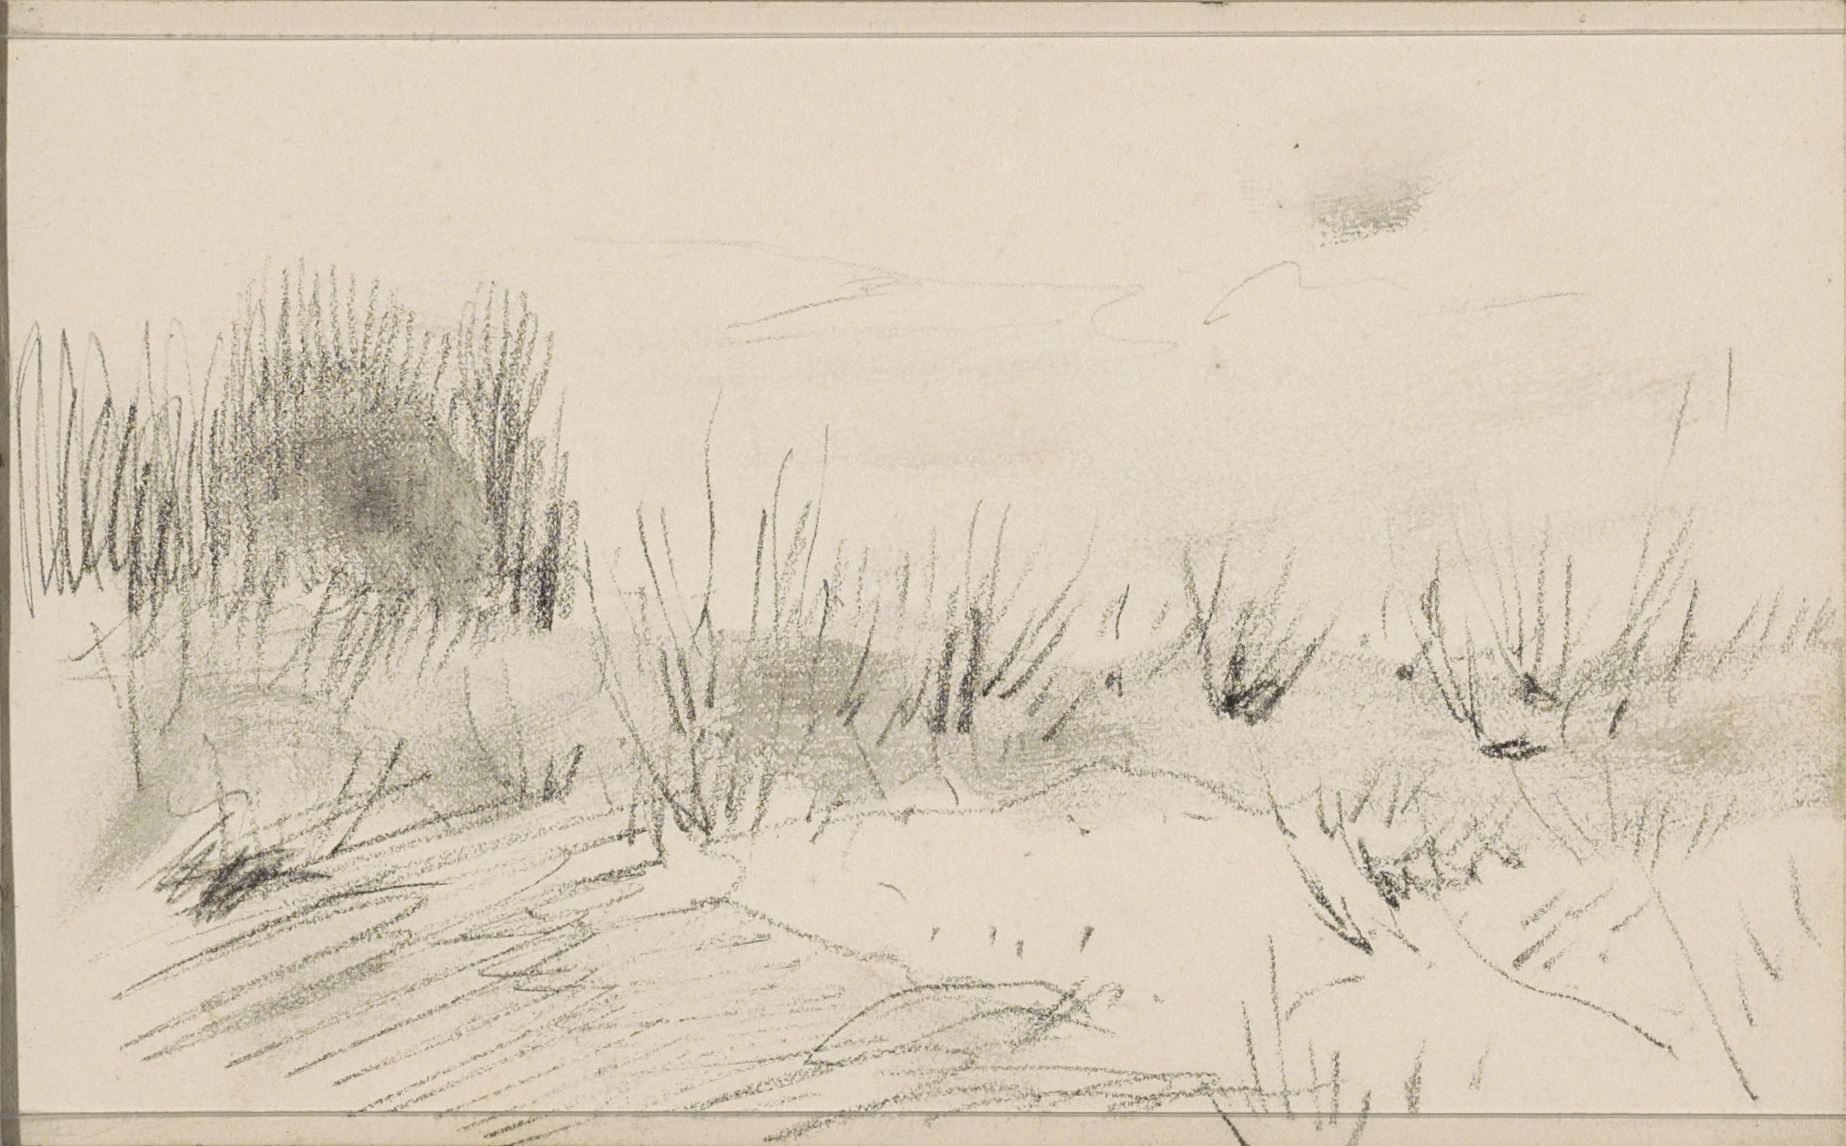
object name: sketchbook leaf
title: Duinlandschap met helmgras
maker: anton mauve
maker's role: draughtsman, painter, print maker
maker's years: 1838-1888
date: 1876-1888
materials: chalk, paper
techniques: brush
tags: dune coast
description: Blad 18 recto uit een schetsboek met 34 bladen.